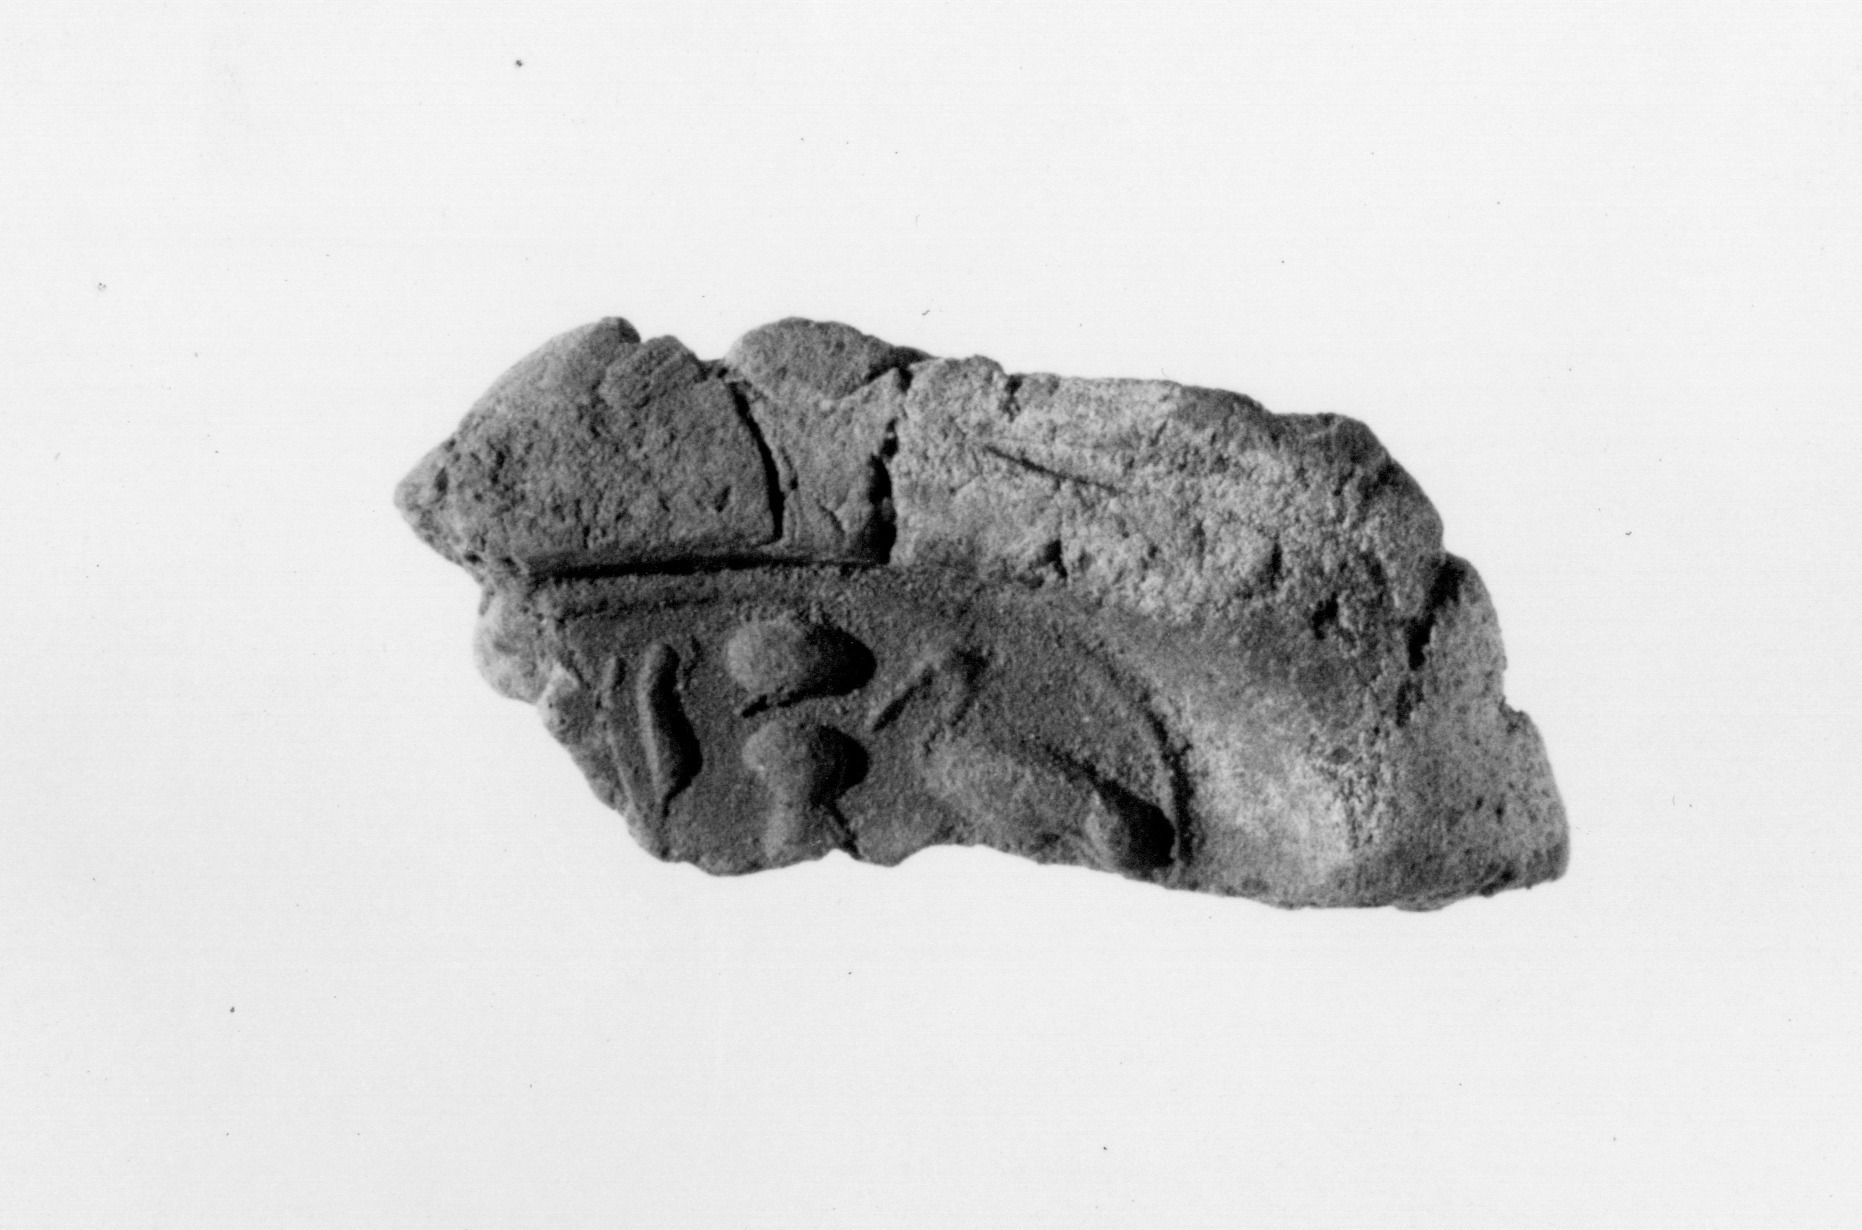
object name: sealing, nebmaatre, amenhotep iii, horus, re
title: Document Sealing With the Throne Name of Amenhotep III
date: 1390-1352 BCE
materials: mud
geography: egypt